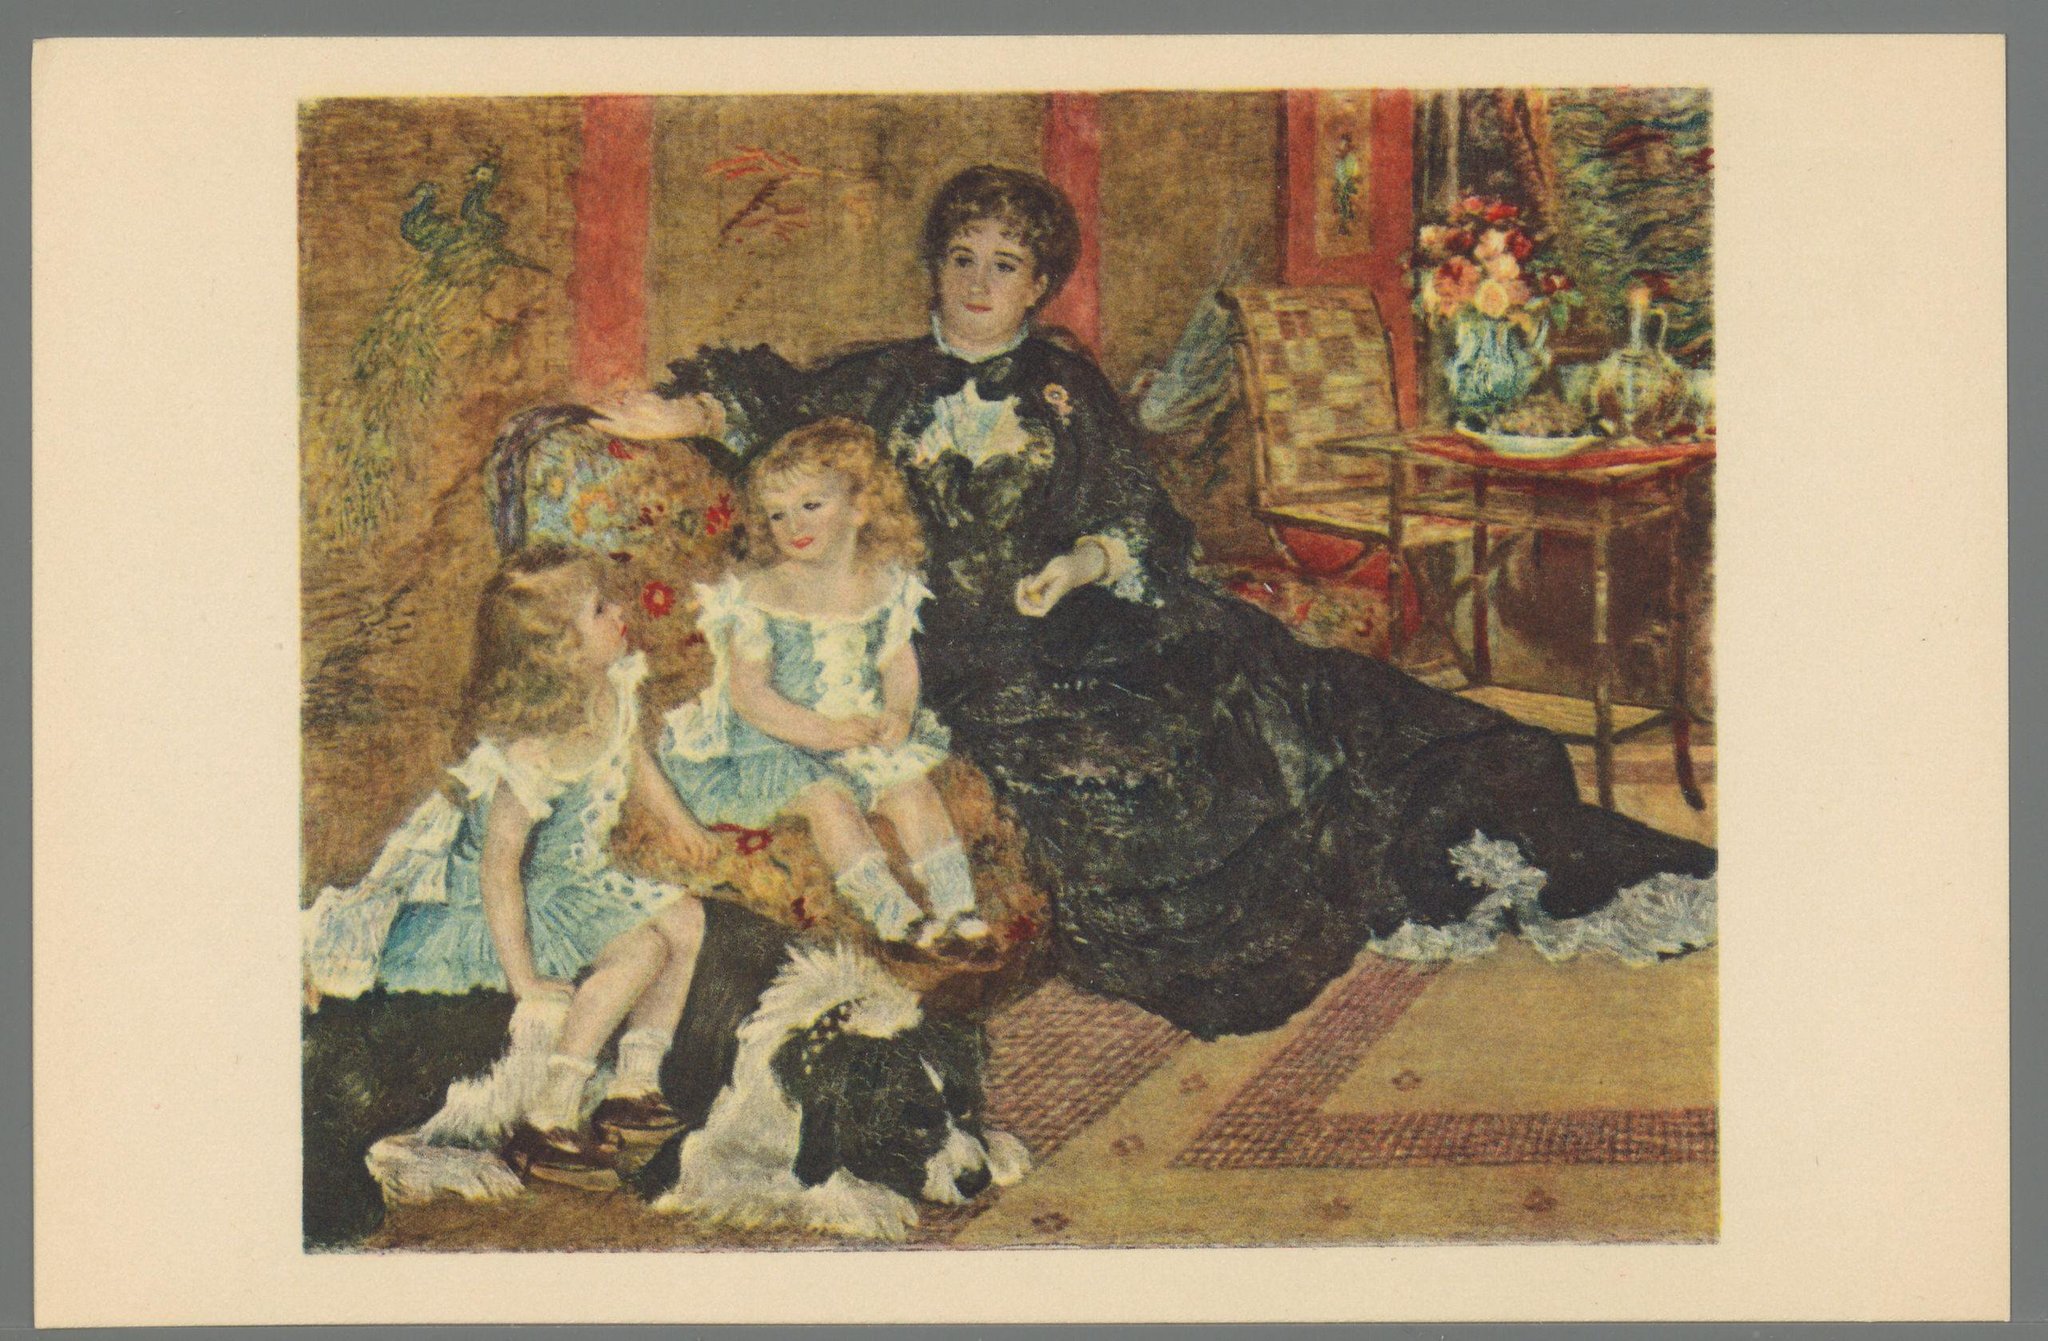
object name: ansichtkaart, prentbriefkaart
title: Madame Charpentier and Her Children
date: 1907-1940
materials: cardboard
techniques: photograph, lithograph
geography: new york city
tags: mother with son(s) and daughter(s) (mother-love), drawing-room, 'salon', dog